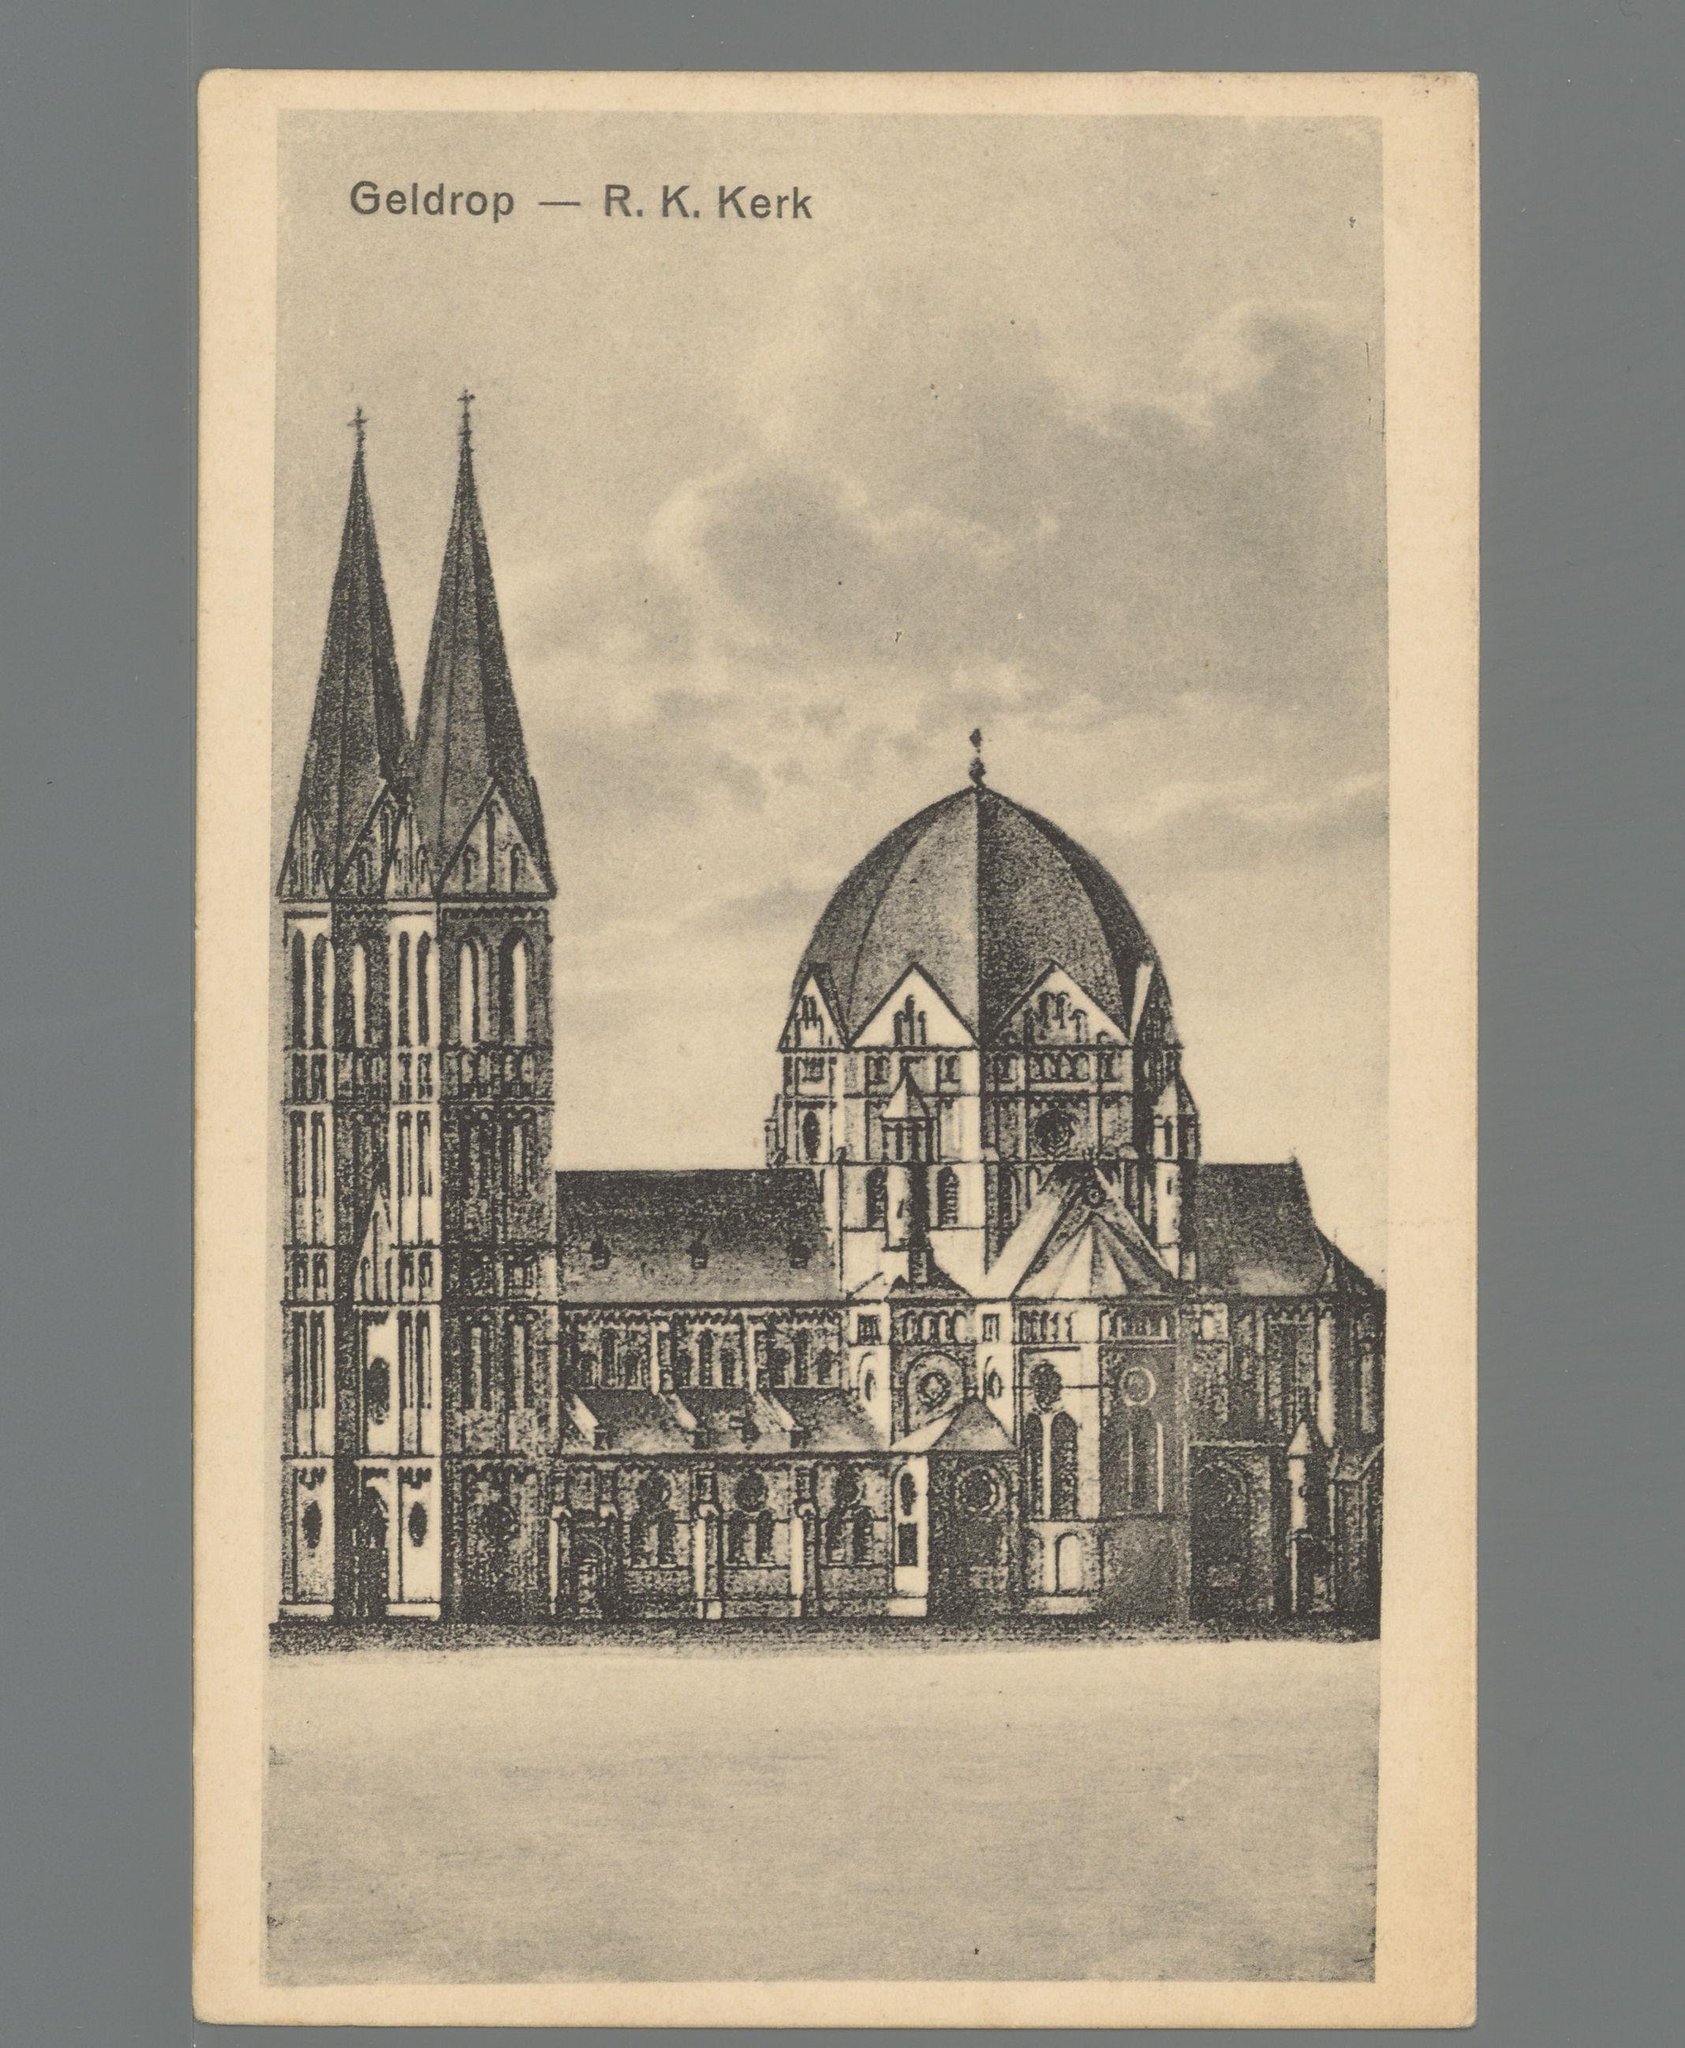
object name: photomechanical print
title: Geldrop - R.K. Kerk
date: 1913-1928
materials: cardboard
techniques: photograph, writing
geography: geldrop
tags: church (exterior)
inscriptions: postage stamp